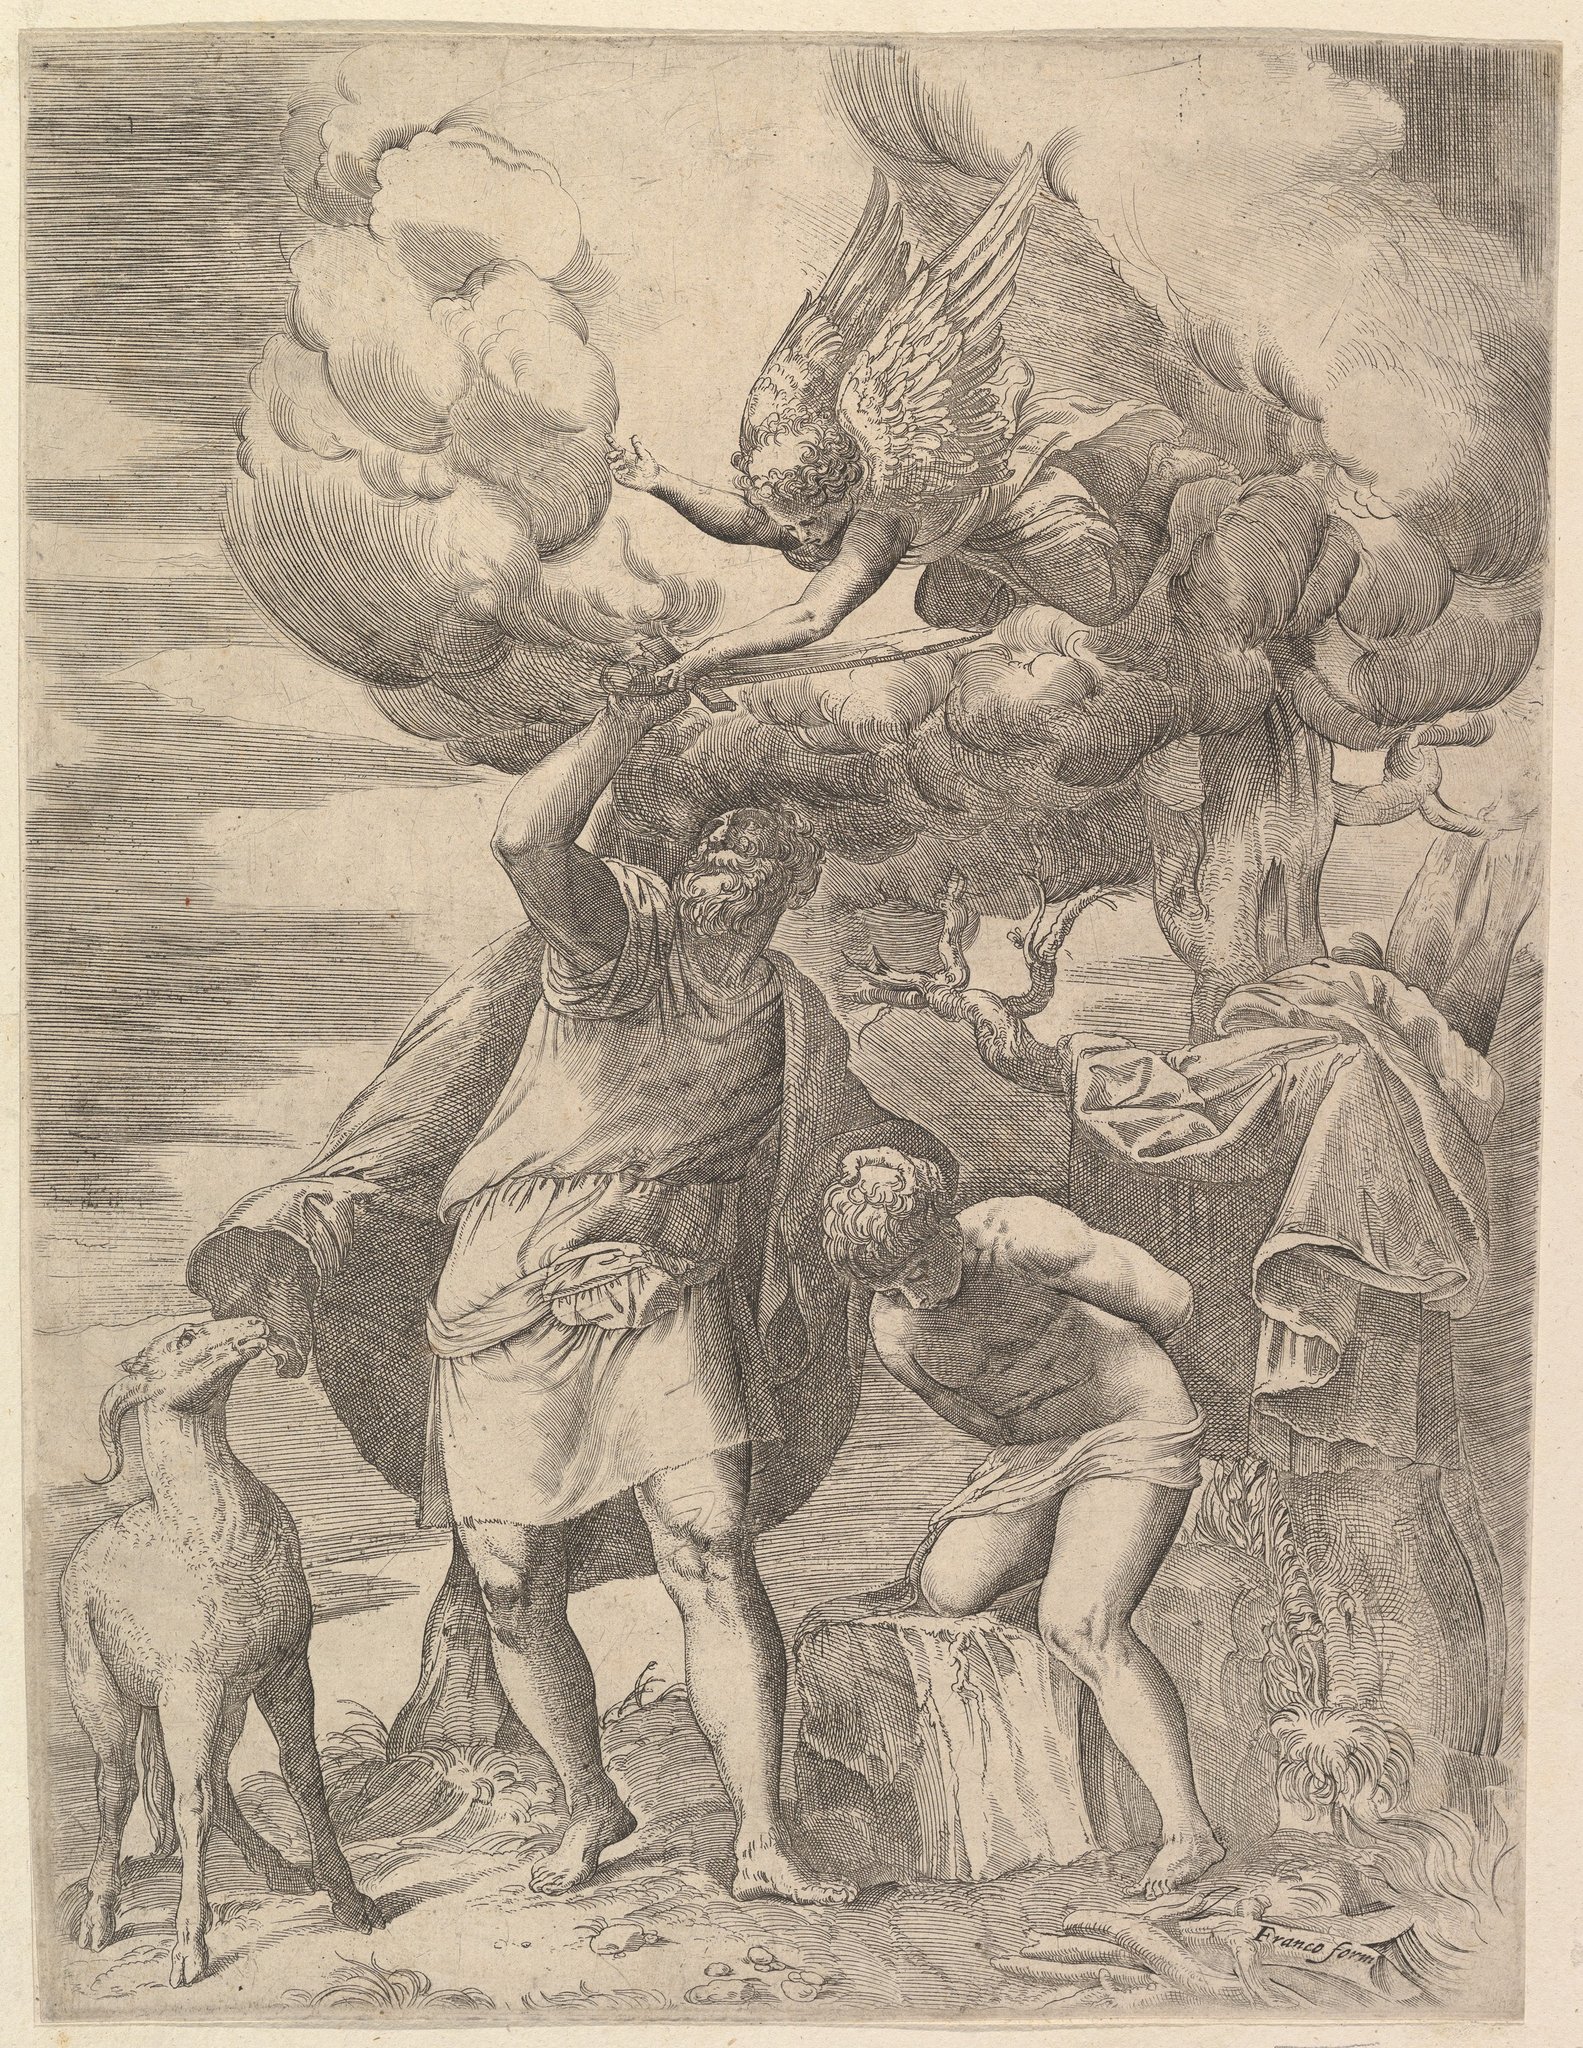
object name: print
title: The Angel Staying the Arm of Abraham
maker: battista franco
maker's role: artist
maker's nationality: italian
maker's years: 1510-1561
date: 1552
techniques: engraving, etching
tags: animals,angels,abraham